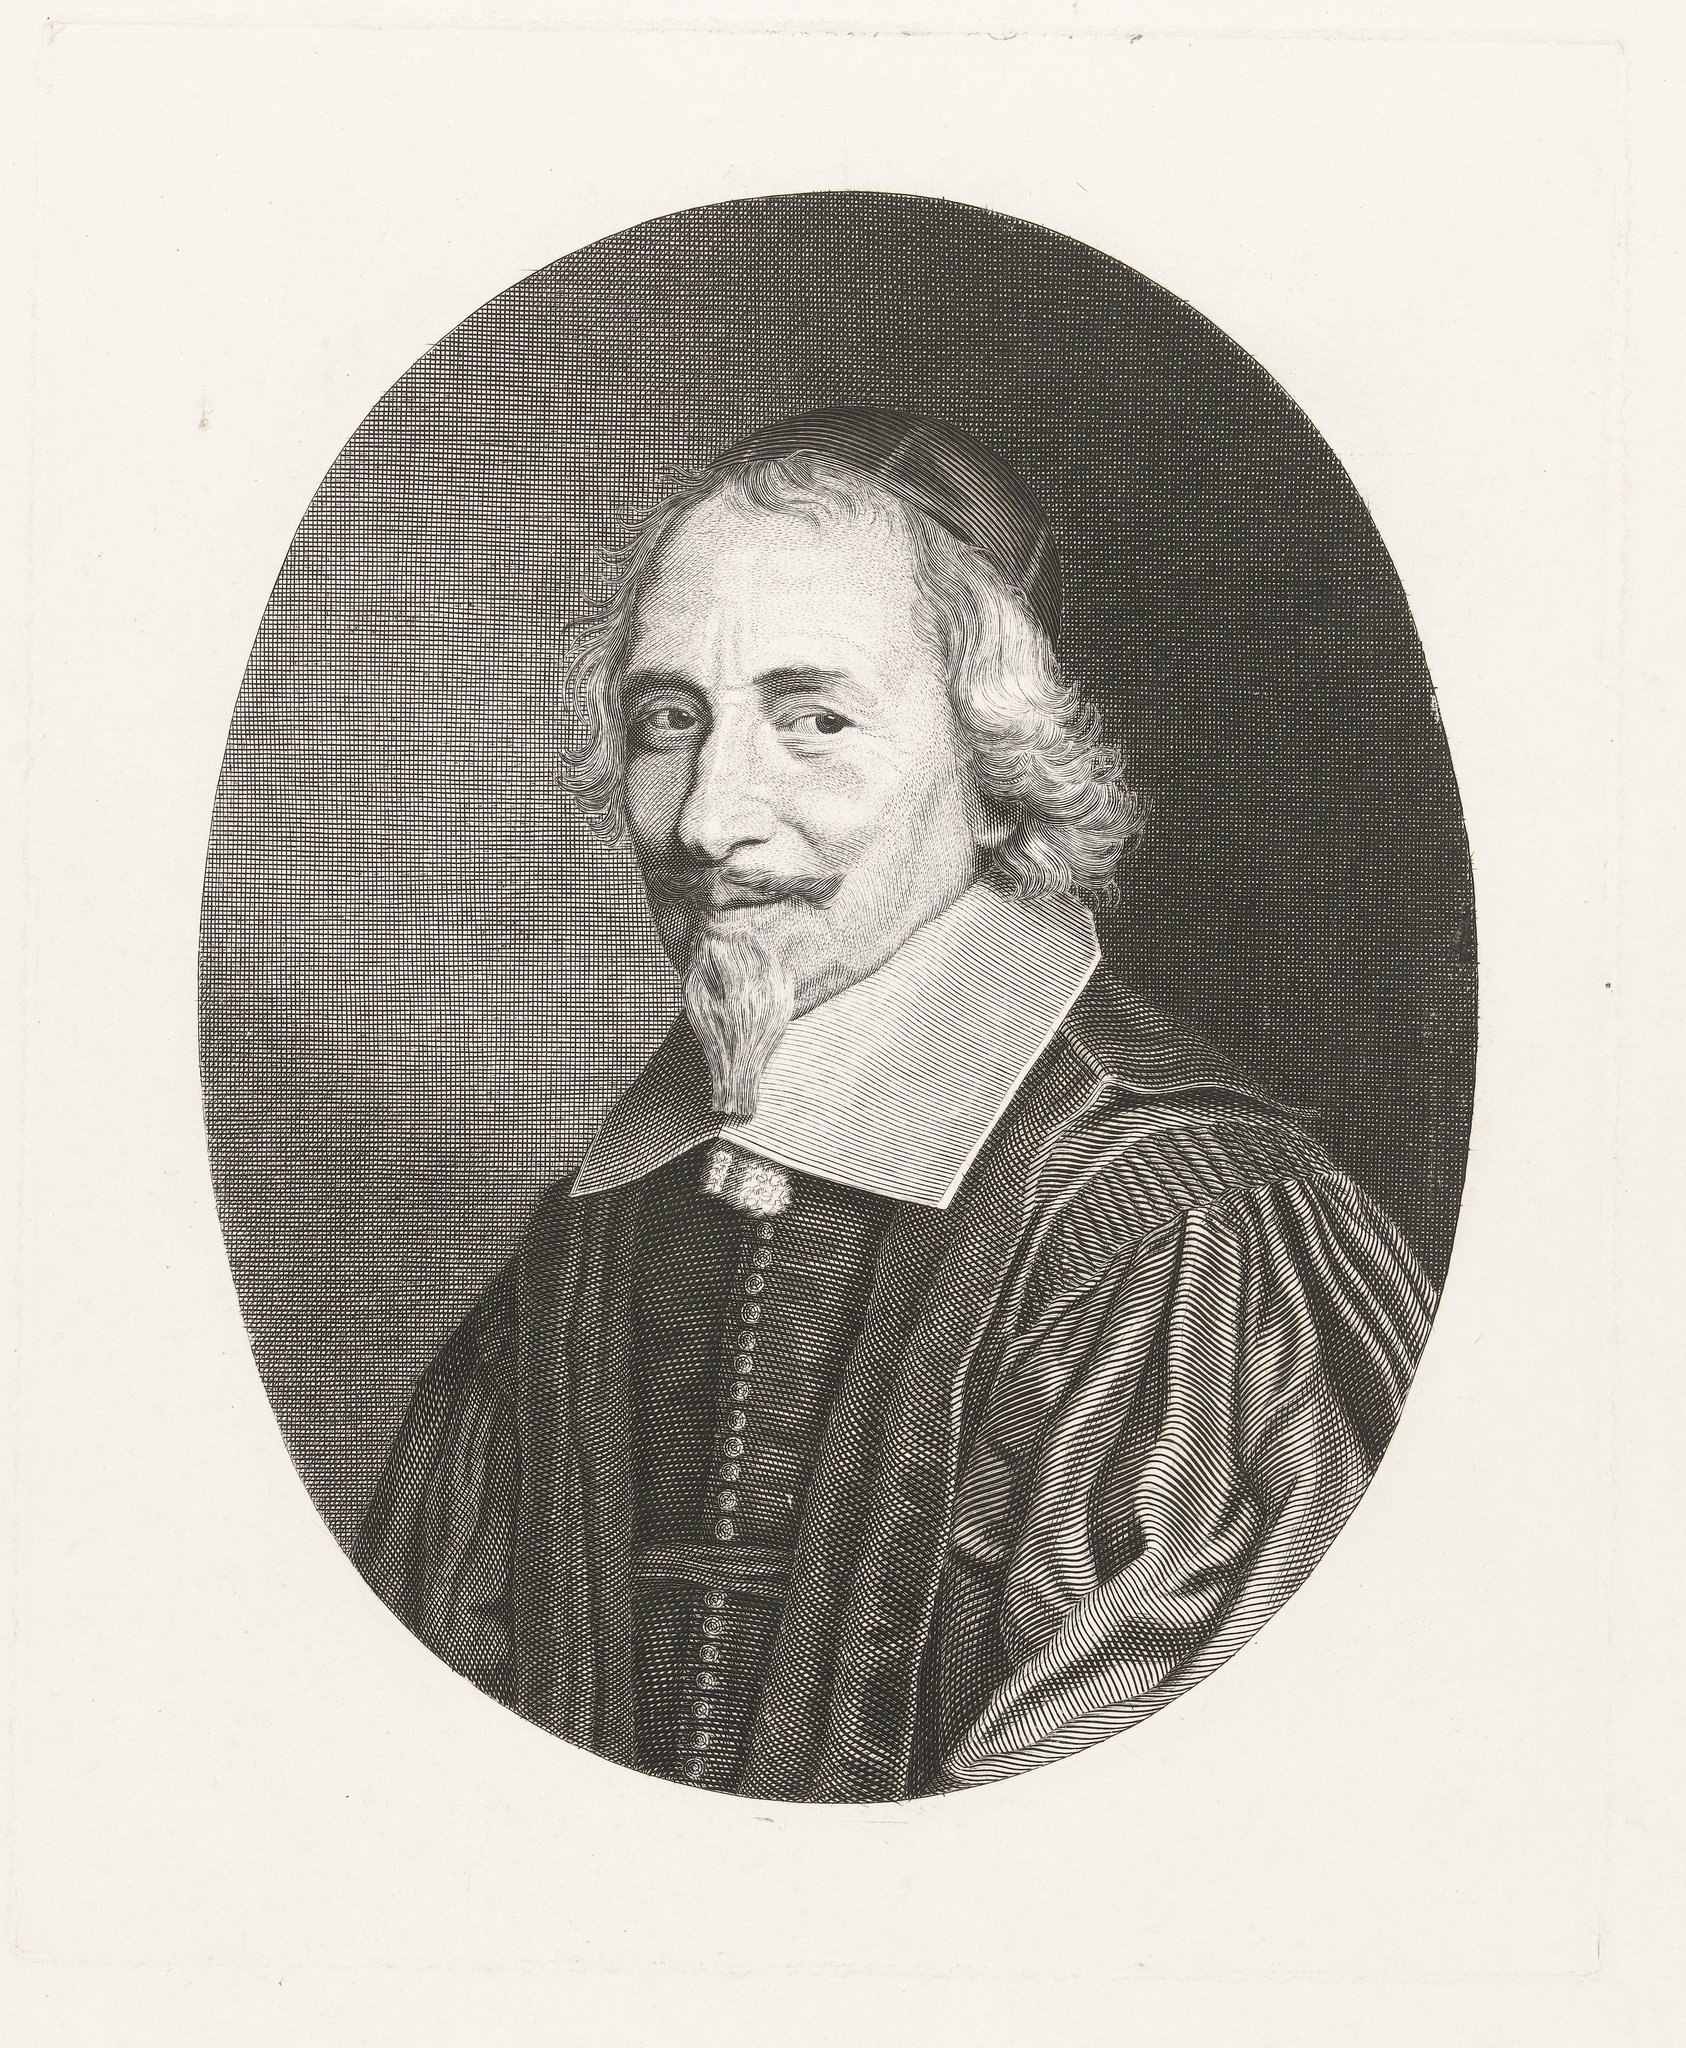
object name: print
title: Portret van kardinaal Mazarin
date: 1855-1915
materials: paper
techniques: engraving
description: Portret in ovale lijst van kardinaal Jules Mazarin, eerste minister van Frankrijk. Buste naar links. Mazarin draagt een kardinaalsgewaad met een stijve kraag.